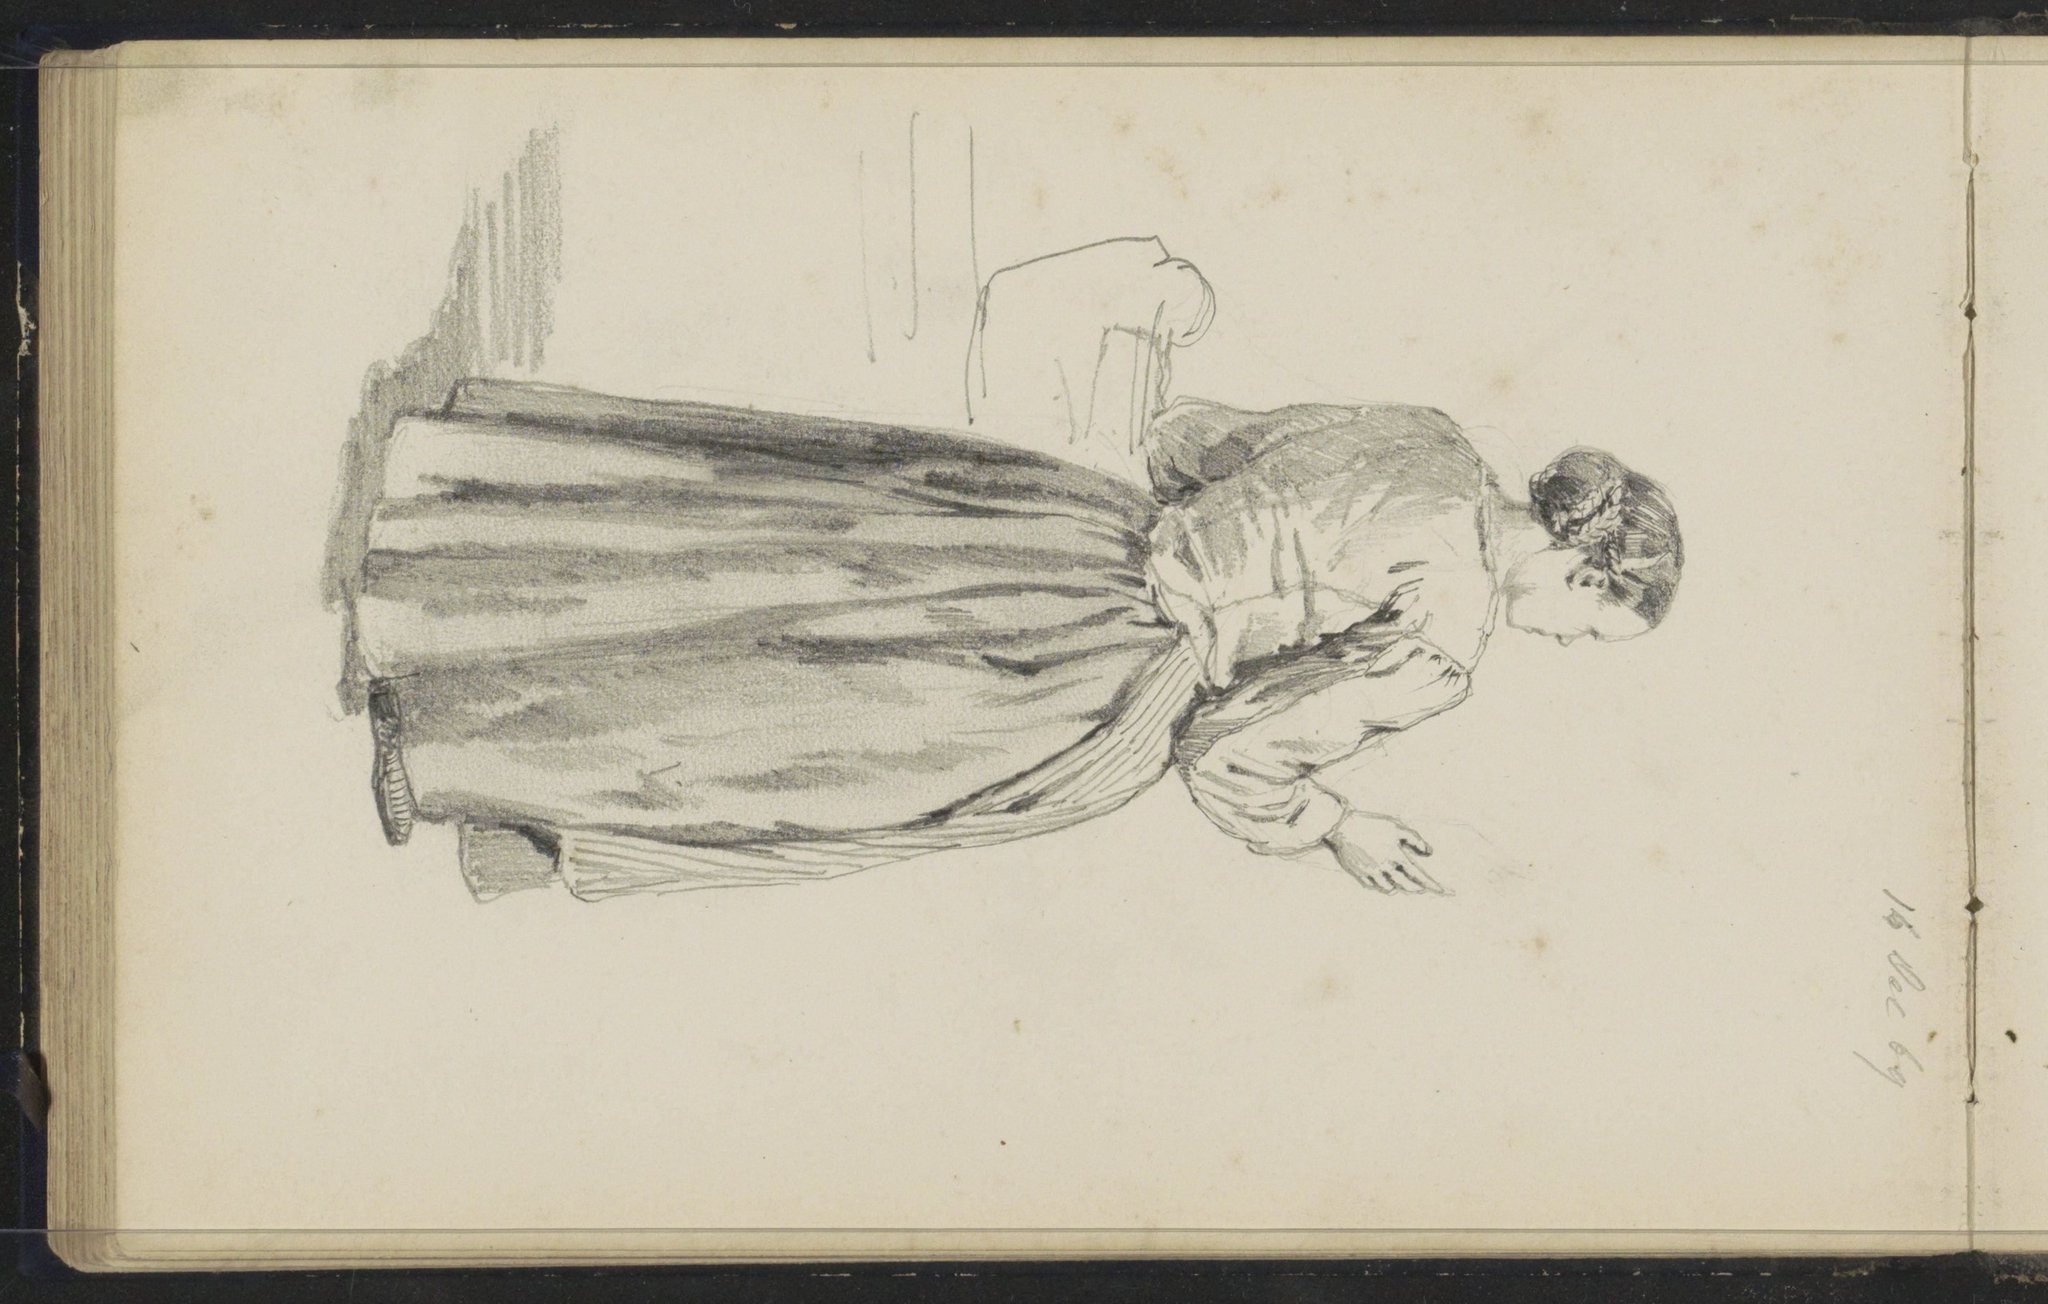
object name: sketchbook leaf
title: Vrouw naast een mand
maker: cornelis springer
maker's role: draughtsman, painter, print maker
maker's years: 1817-1891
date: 1869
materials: paper, pencil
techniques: stumping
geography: netherlands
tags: adult woman, container made of plant material other than wood: basket, standing figure - aa - female human figure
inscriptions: date: ‘16 Dec 69’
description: Staande vrouw met een schort. Haar linker arm rust op een mand. Blad 38 verso uit een schetsboek met 40 bladen, vervaardigd in Woerden en Gouda.